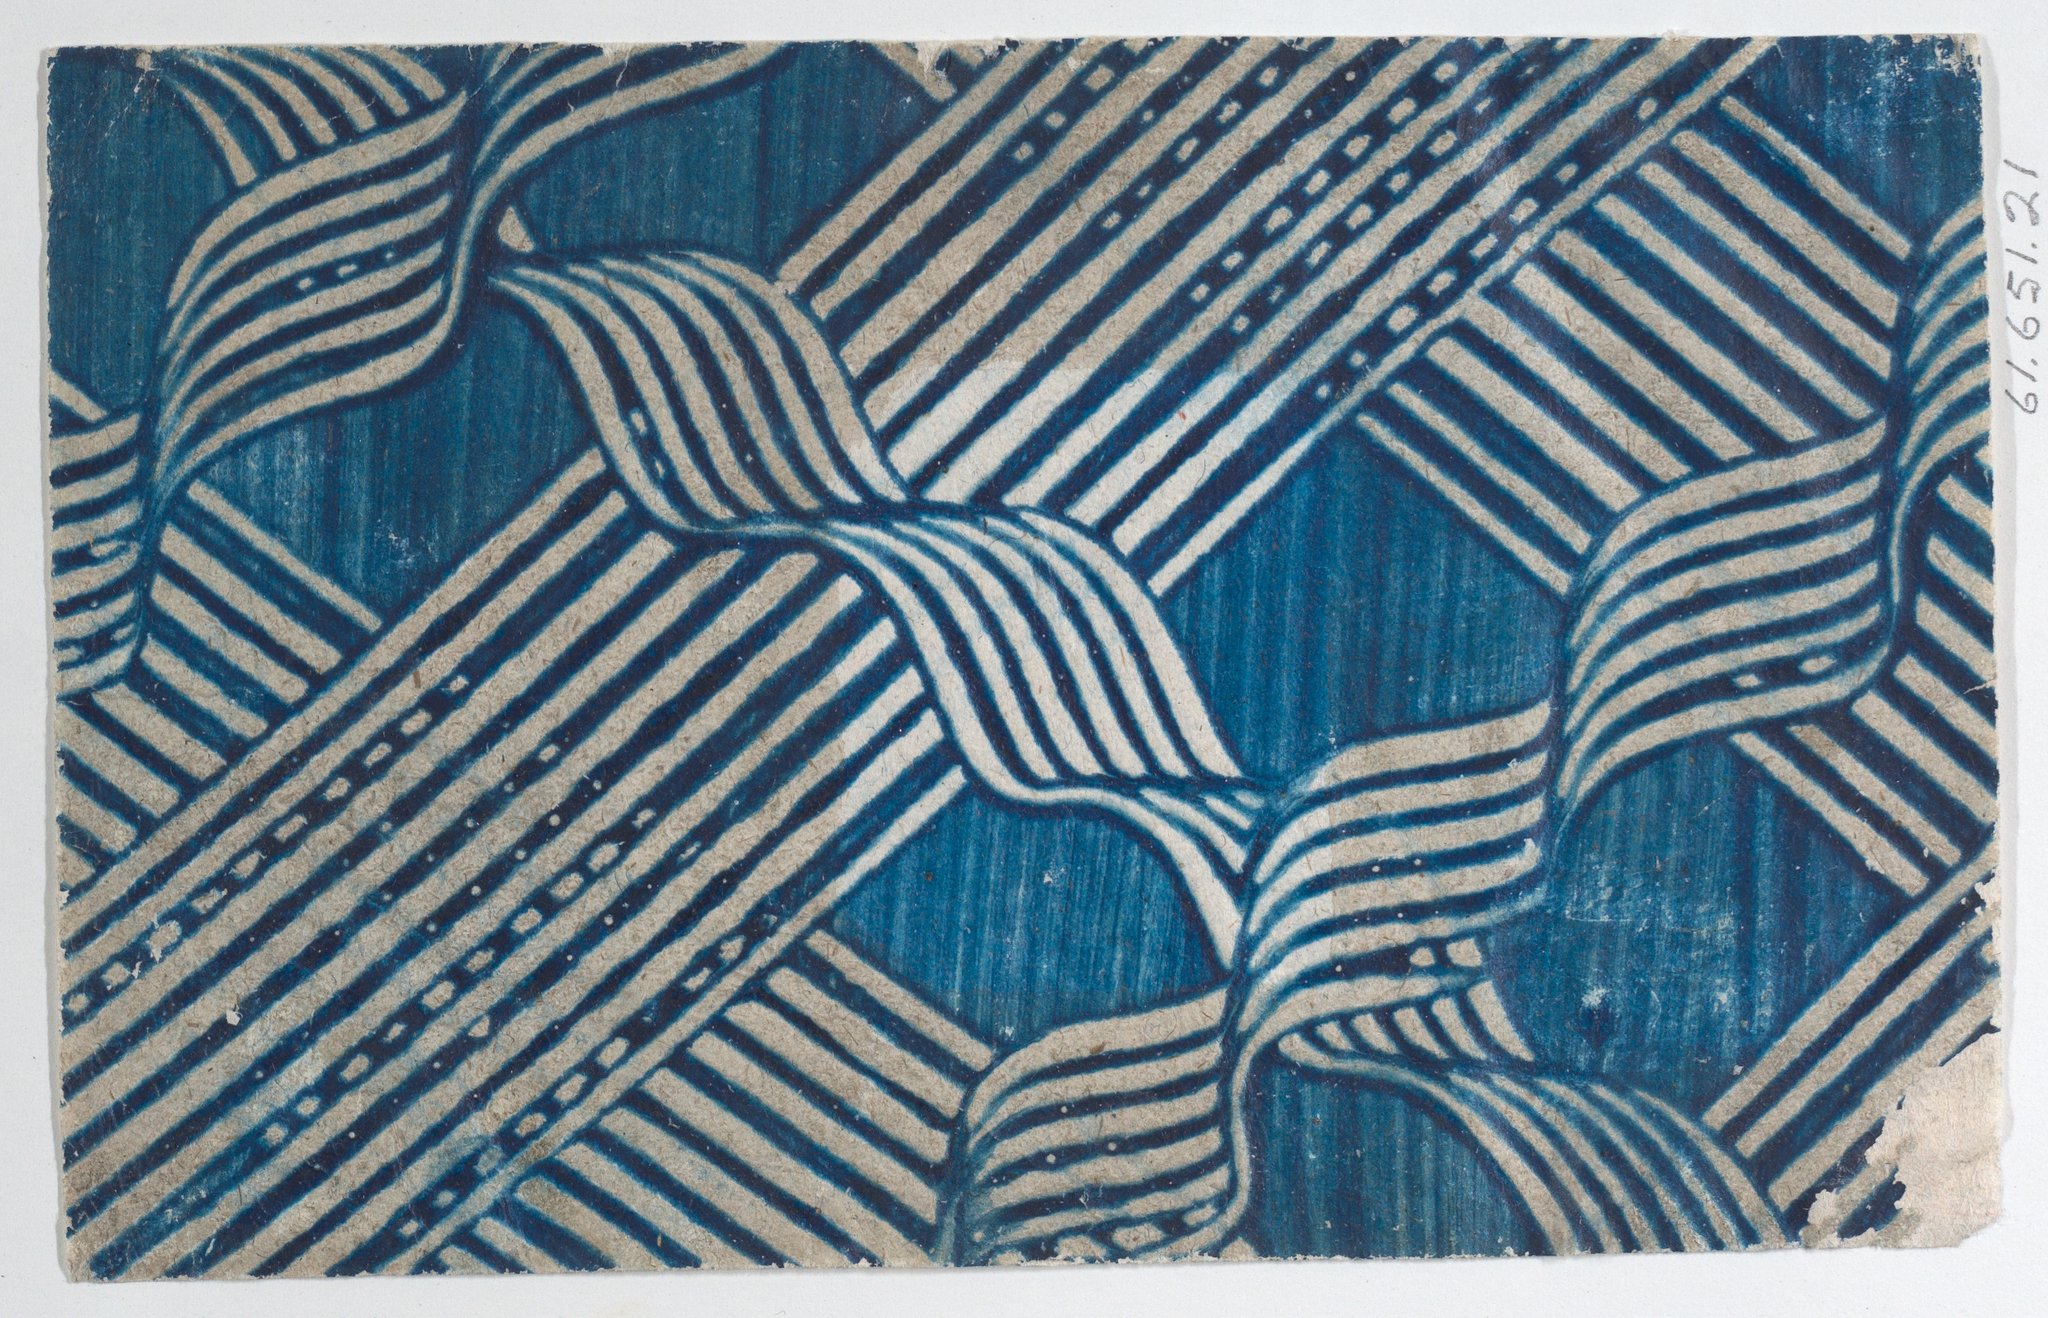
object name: print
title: Blue paste paper with stripe and ribbon pattern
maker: Anonymous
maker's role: artist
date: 1701-1800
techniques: relief print